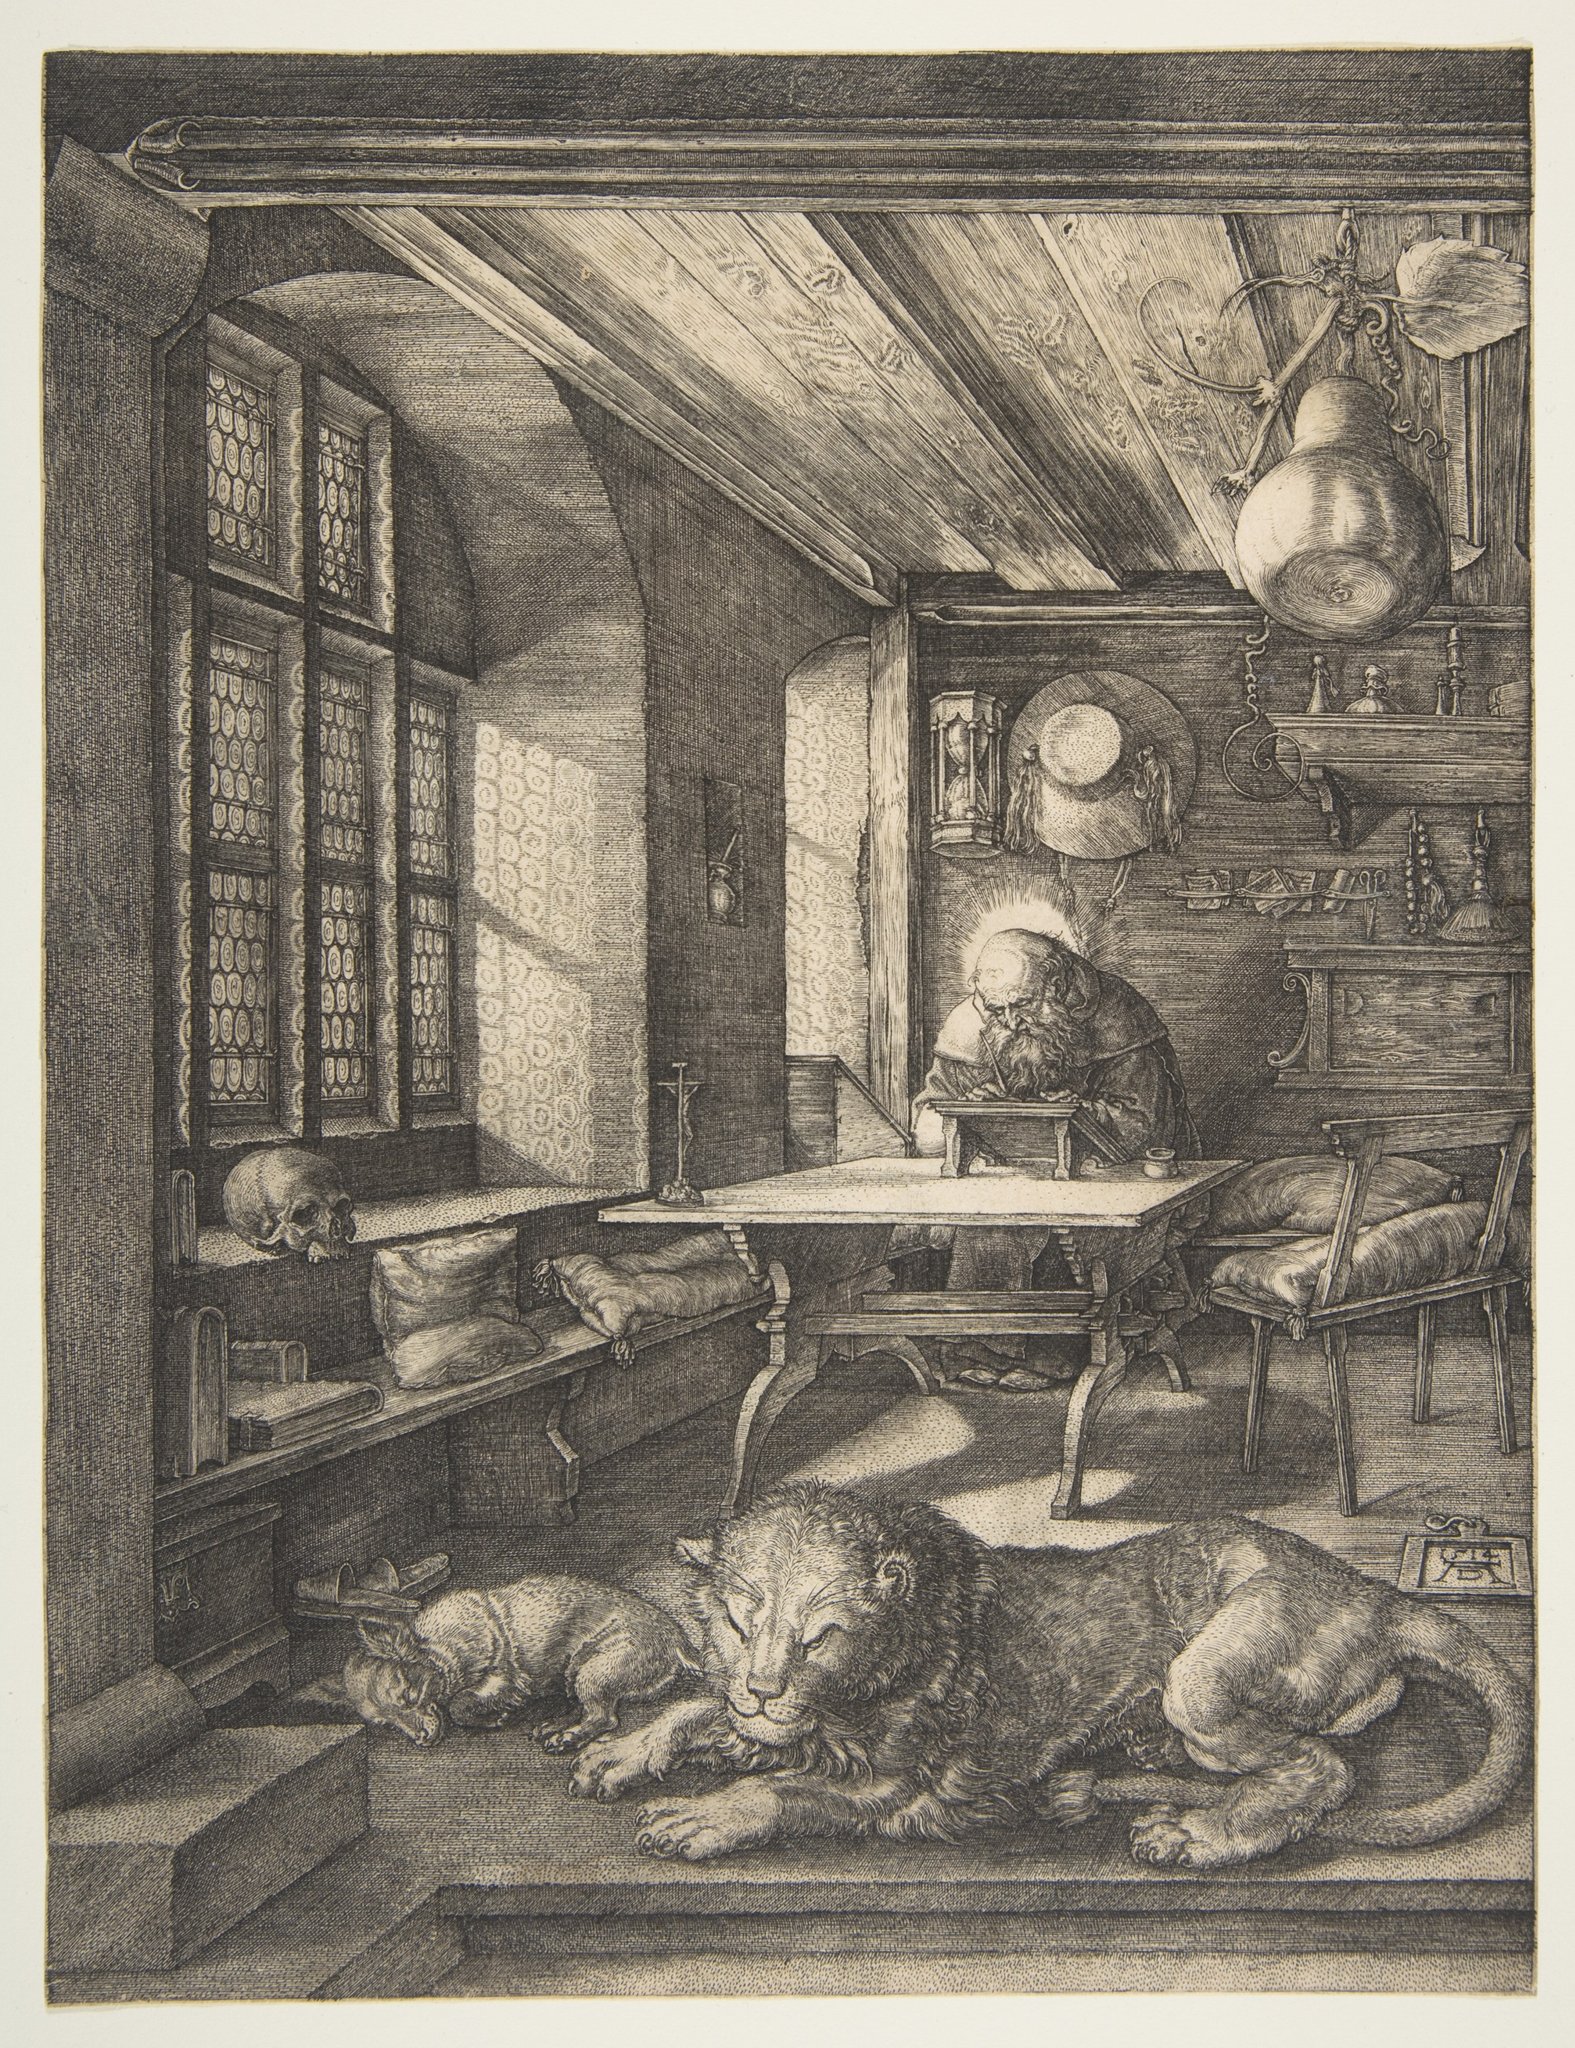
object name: print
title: Saint Jerome in His Study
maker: albrecht dürer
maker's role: artist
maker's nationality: german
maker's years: 1471-1528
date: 1514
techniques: engraving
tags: interiors,skulls,lions,saint jerome